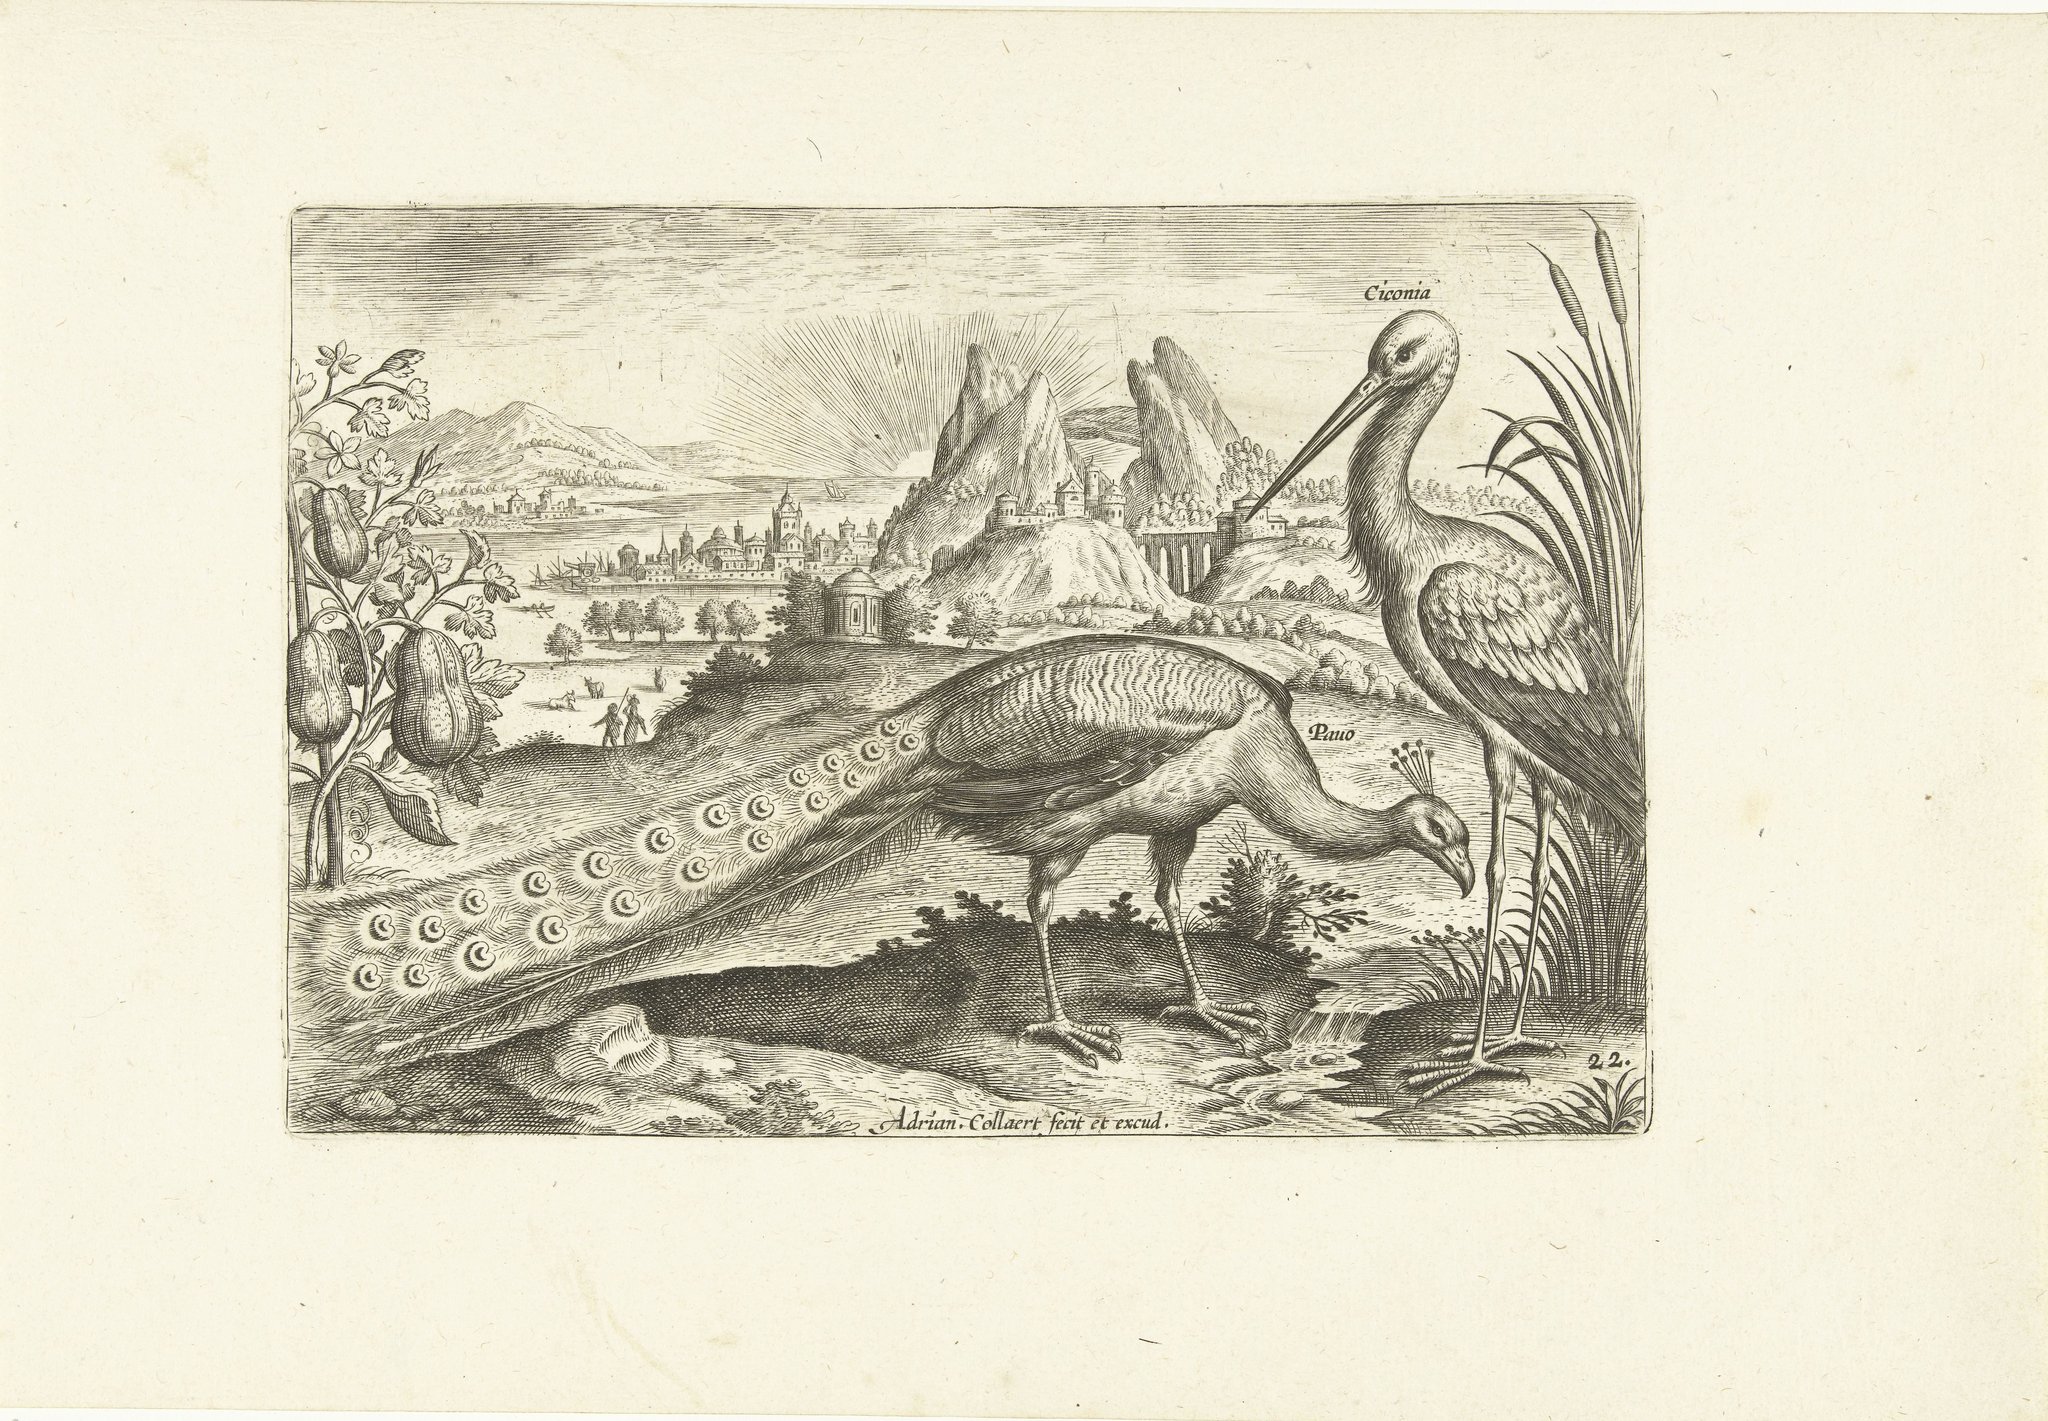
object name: print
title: Avivm Vivae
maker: adriaen collaert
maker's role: draughtsman, print maker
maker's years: 1560-1618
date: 1598-1602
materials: paper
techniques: engraving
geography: antwerp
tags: shore-birds and wading-birds: stork, ornamental birds: peacock, landscapes in the temperate zone (+ landscape with figures, staffage)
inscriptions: collector's mark: Lugt 2228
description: Een pauw en een ooievaar in een landschap. De prent maakt deel uit van een serie met vogels als onderwerp.